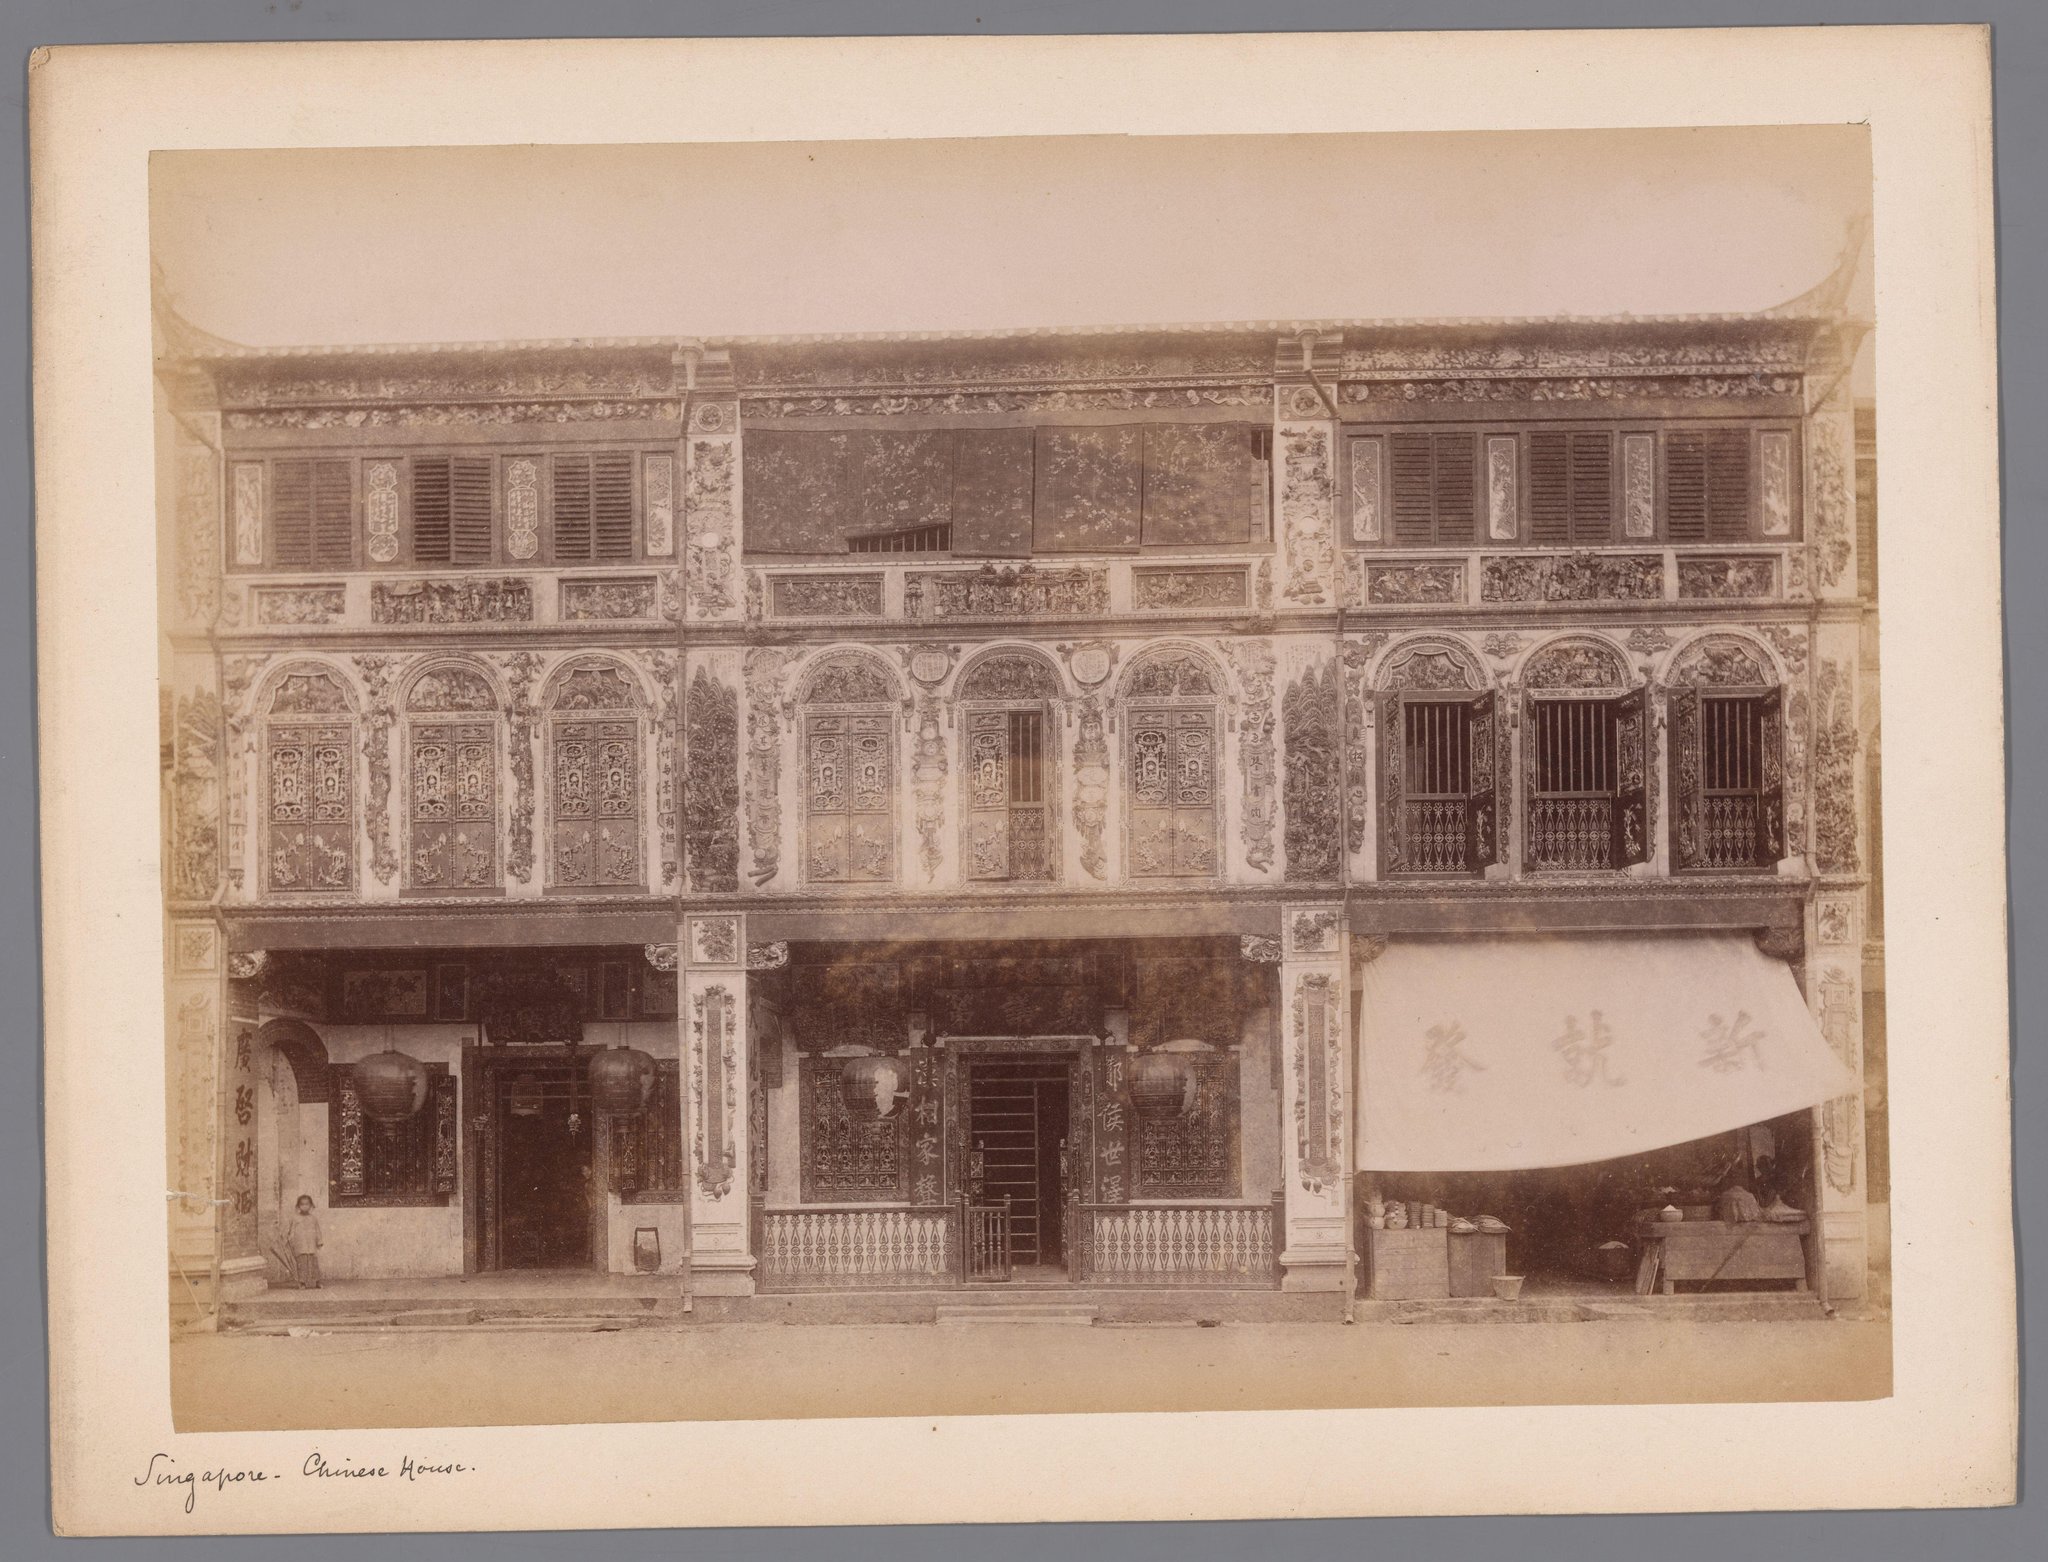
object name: photograph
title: Chinese woningen in Singapore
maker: Anonymous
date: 1860-1900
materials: cardboard, paper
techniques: albumen print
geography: singapore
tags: civic architecture; edifices; dwellings, singapore